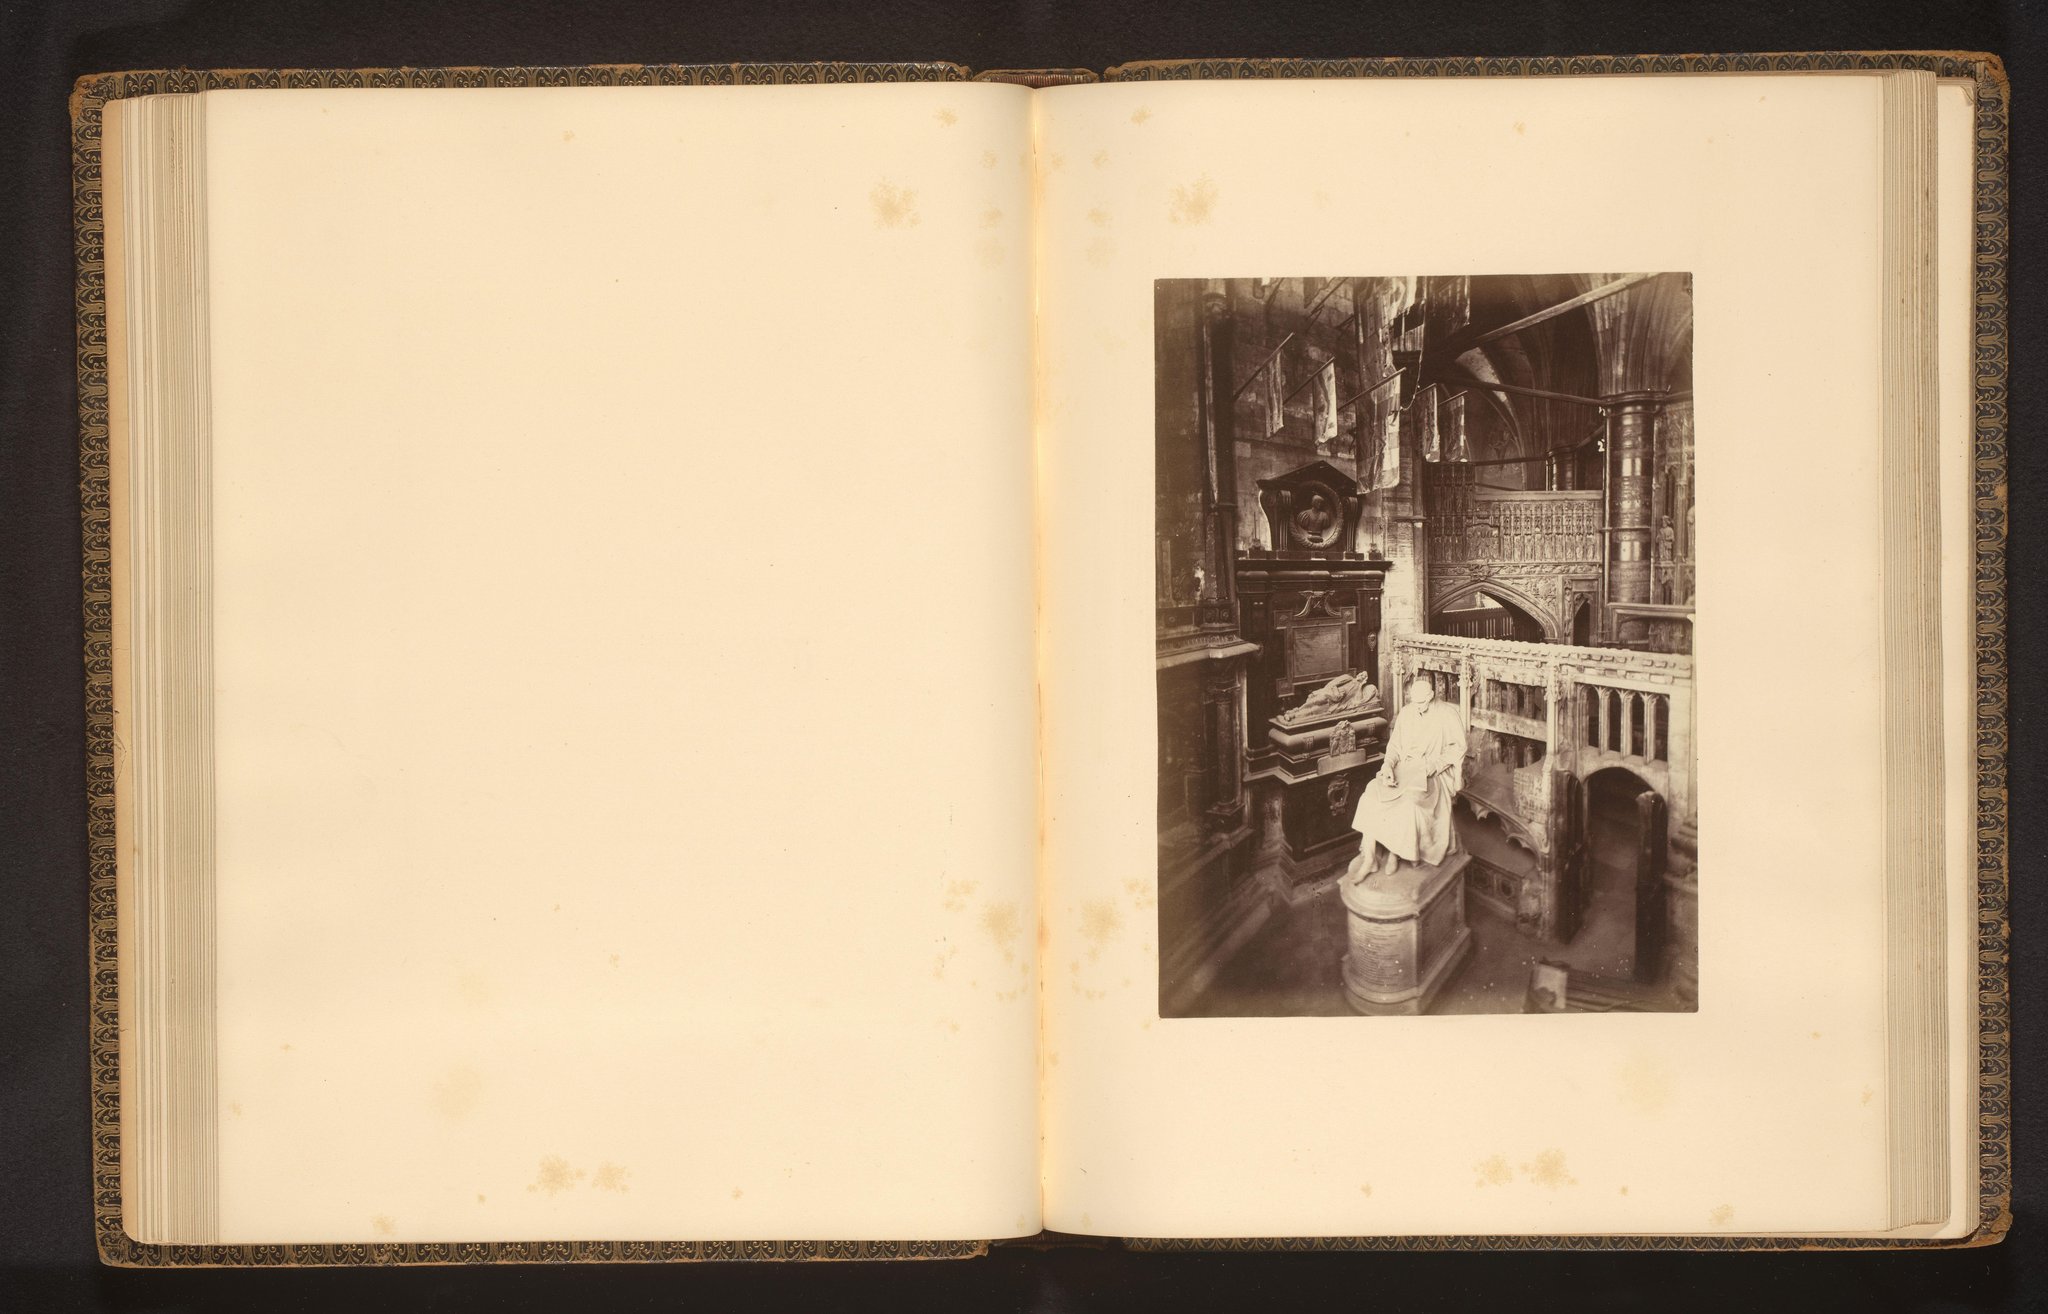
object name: page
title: Kapel van Paulus te Westminster Abbey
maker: john harrington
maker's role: fotograaf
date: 1864-1869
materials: photographic support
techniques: albumen print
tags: abbey, monastery, convent ~ roman catholic church, interior of church, parts of church interior: chapel, westminster abbey